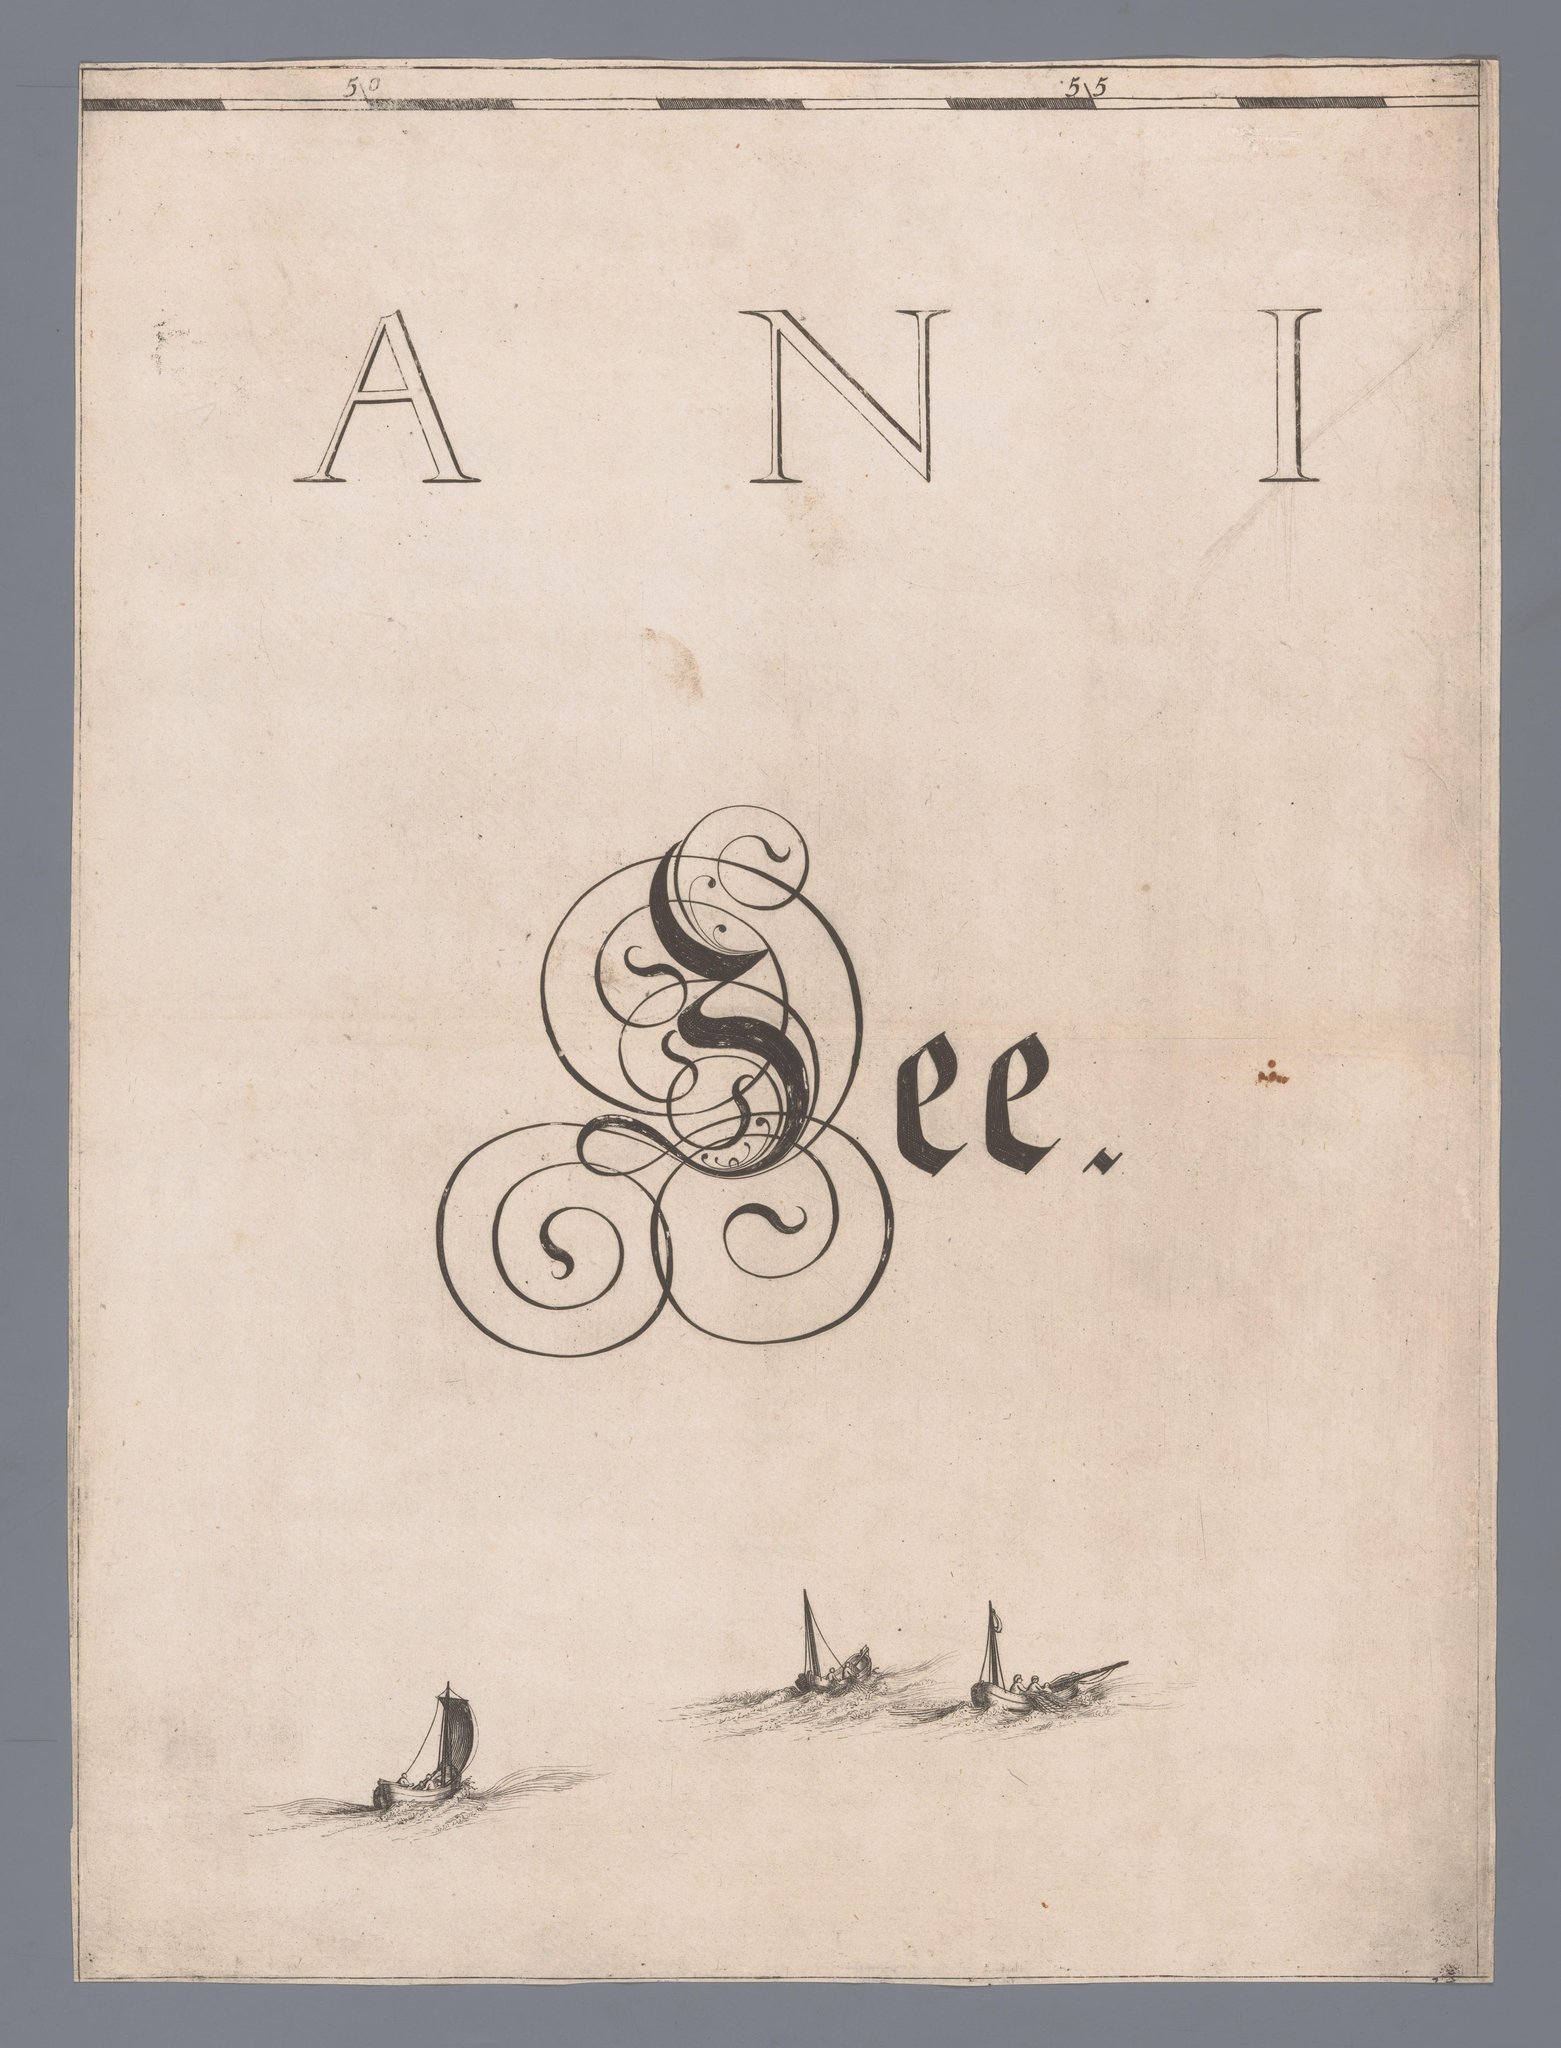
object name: print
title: Kaart van het Graafschap Holland en Utrecht (plaat 4)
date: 1639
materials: paper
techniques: engraving, etching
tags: sailing-ship, sailing-boat, maps, atlases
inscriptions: collector's mark: Lugt 2228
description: Onderdeel van een kaart samengesteld uit 40 bladen. Waarschijnlijk gaat het om de grootste kaart van Holland uit de zeventiende-eeuw. De kaart is uitgegeven in verschillende edities, deze kaart uit 1639 is de eerste editie.